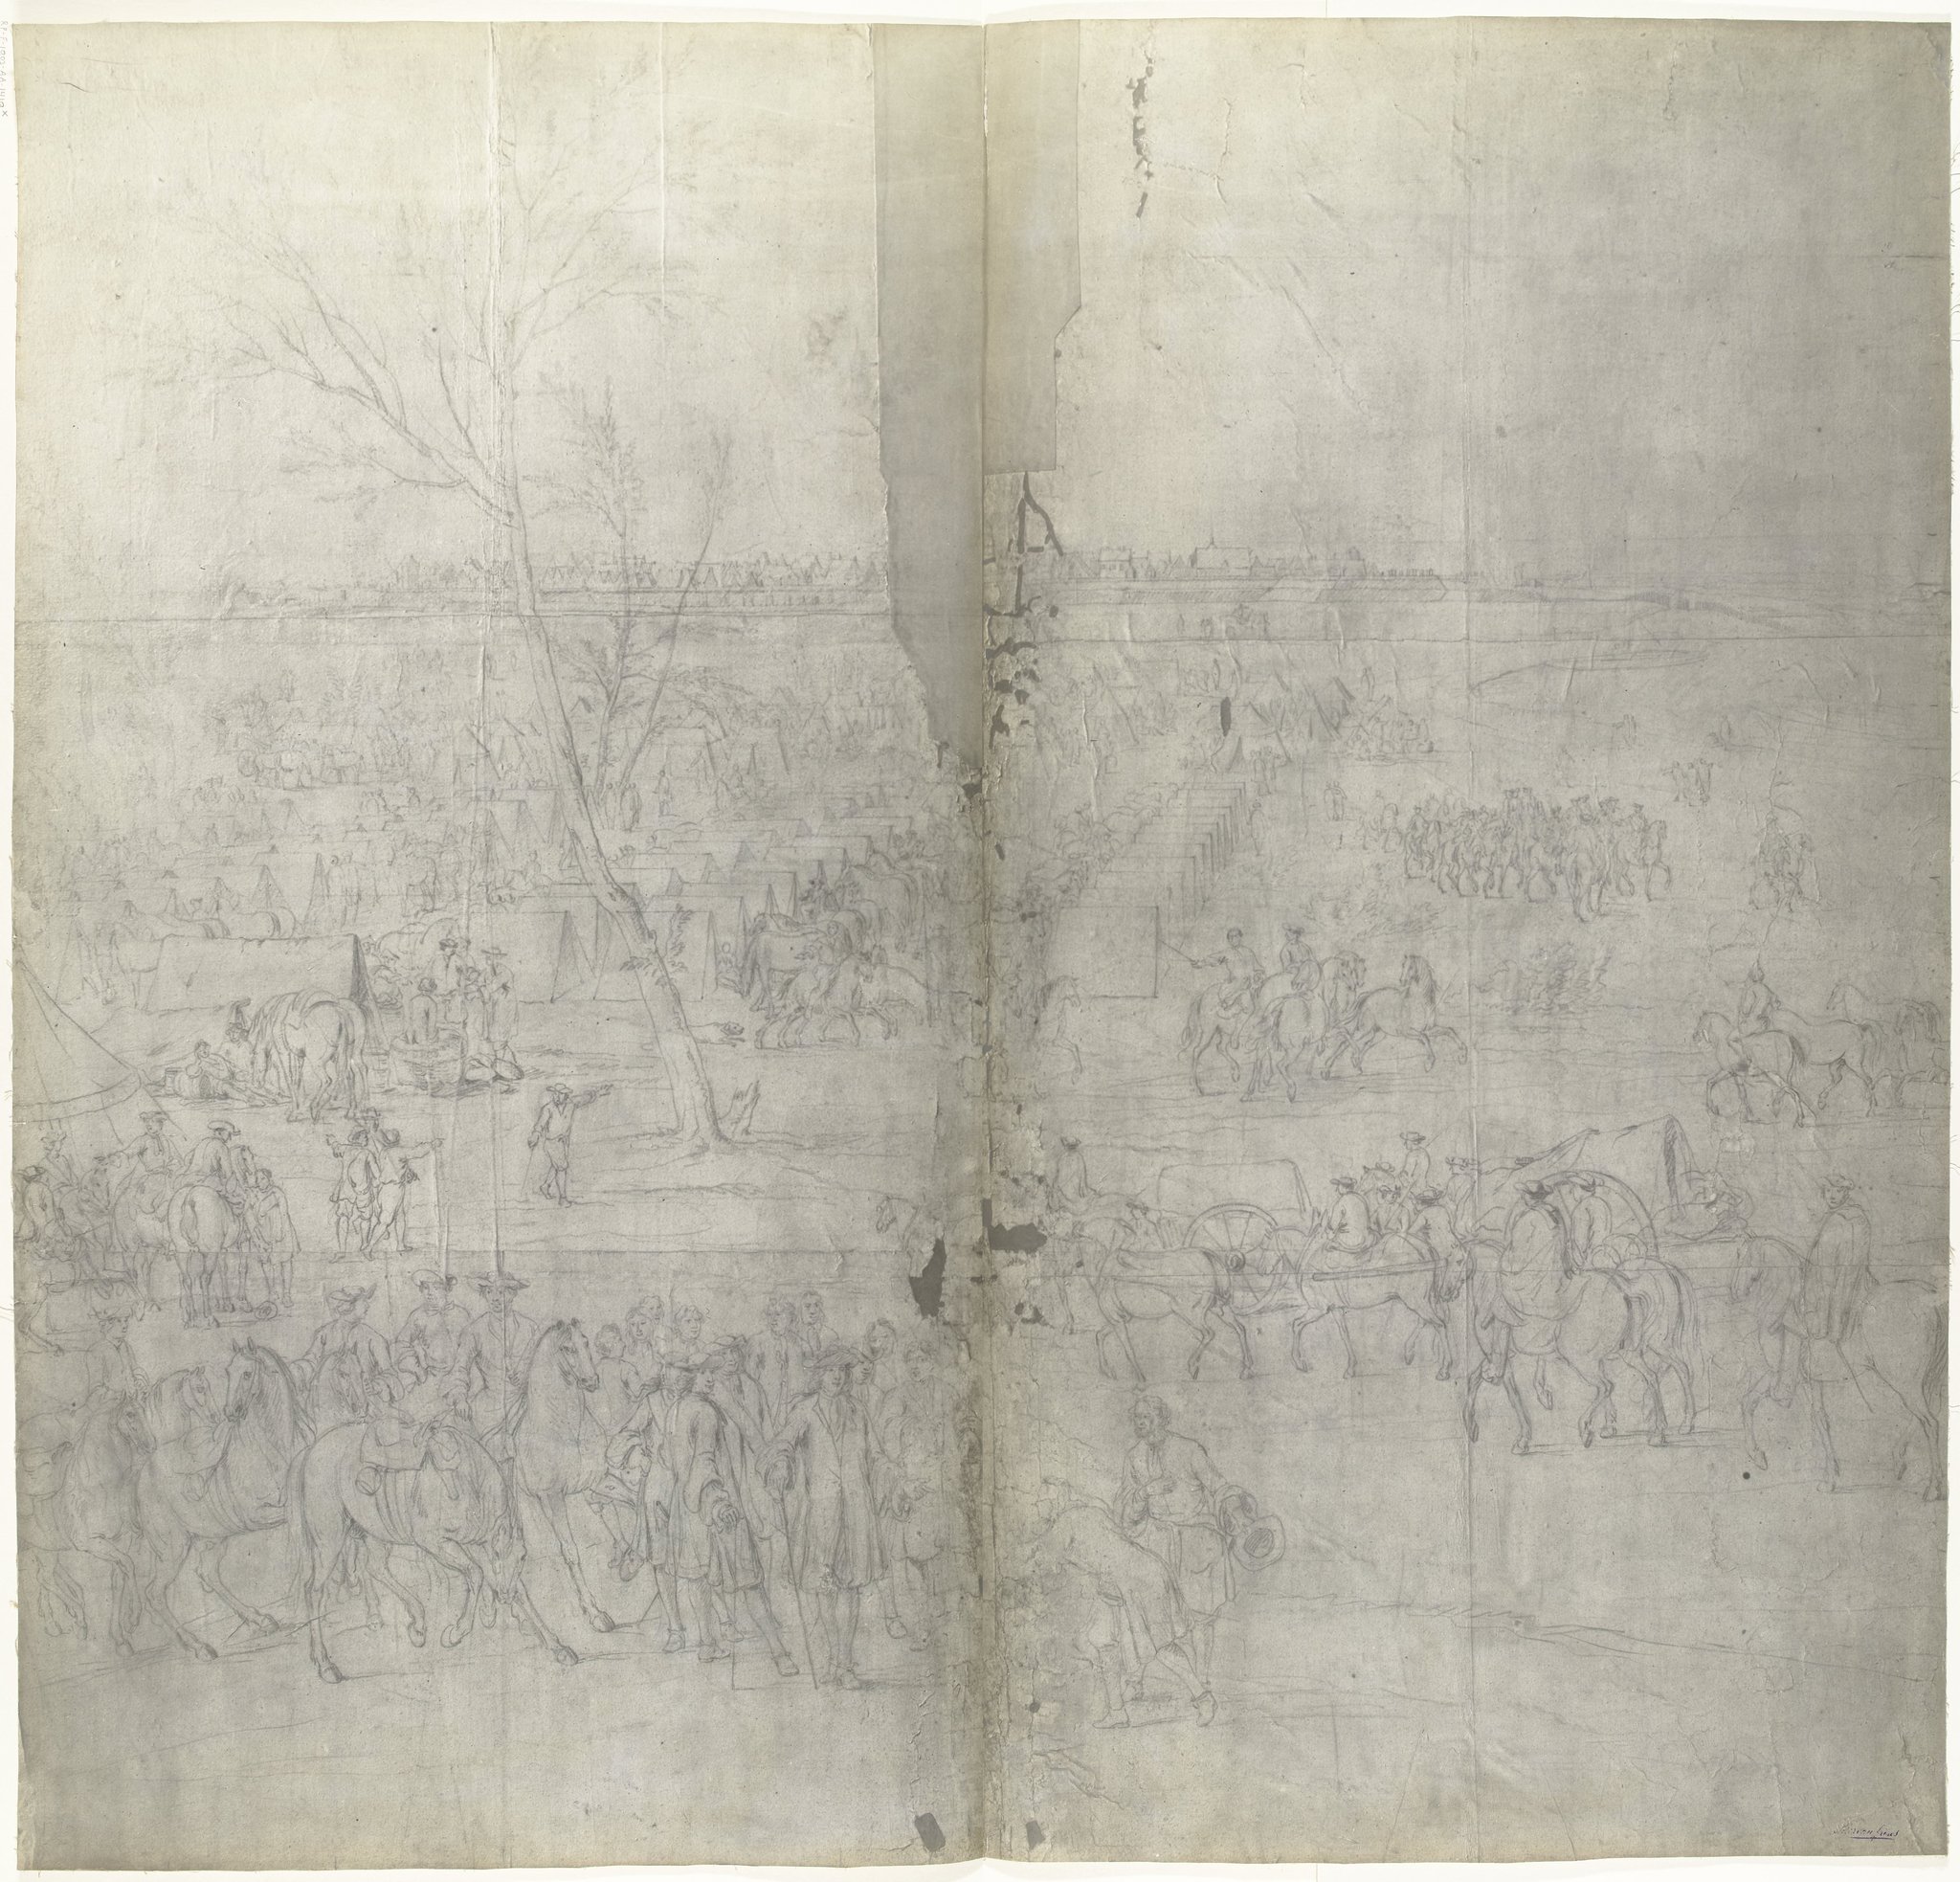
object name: photograph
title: Overgave van Doesburg, 1672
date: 1900-1903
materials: canvas, paper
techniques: gelatin silver print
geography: france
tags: lodewijk xiv (koning van frankrijk), surrender ~ war, rampjaar (disaster year)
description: Foto van een tekening van de overgave van Doesburg, ingenomen door het Franse leger op 21 juni 1672. Afgevaardigden van de stad buigen voor een groep Franse officieren, daarachter het Franse legerkamp. Onderdeel van een serie foto's van tekeningen van veroverde steden tijdens de Franse inval in de Nederlanden in 1672.